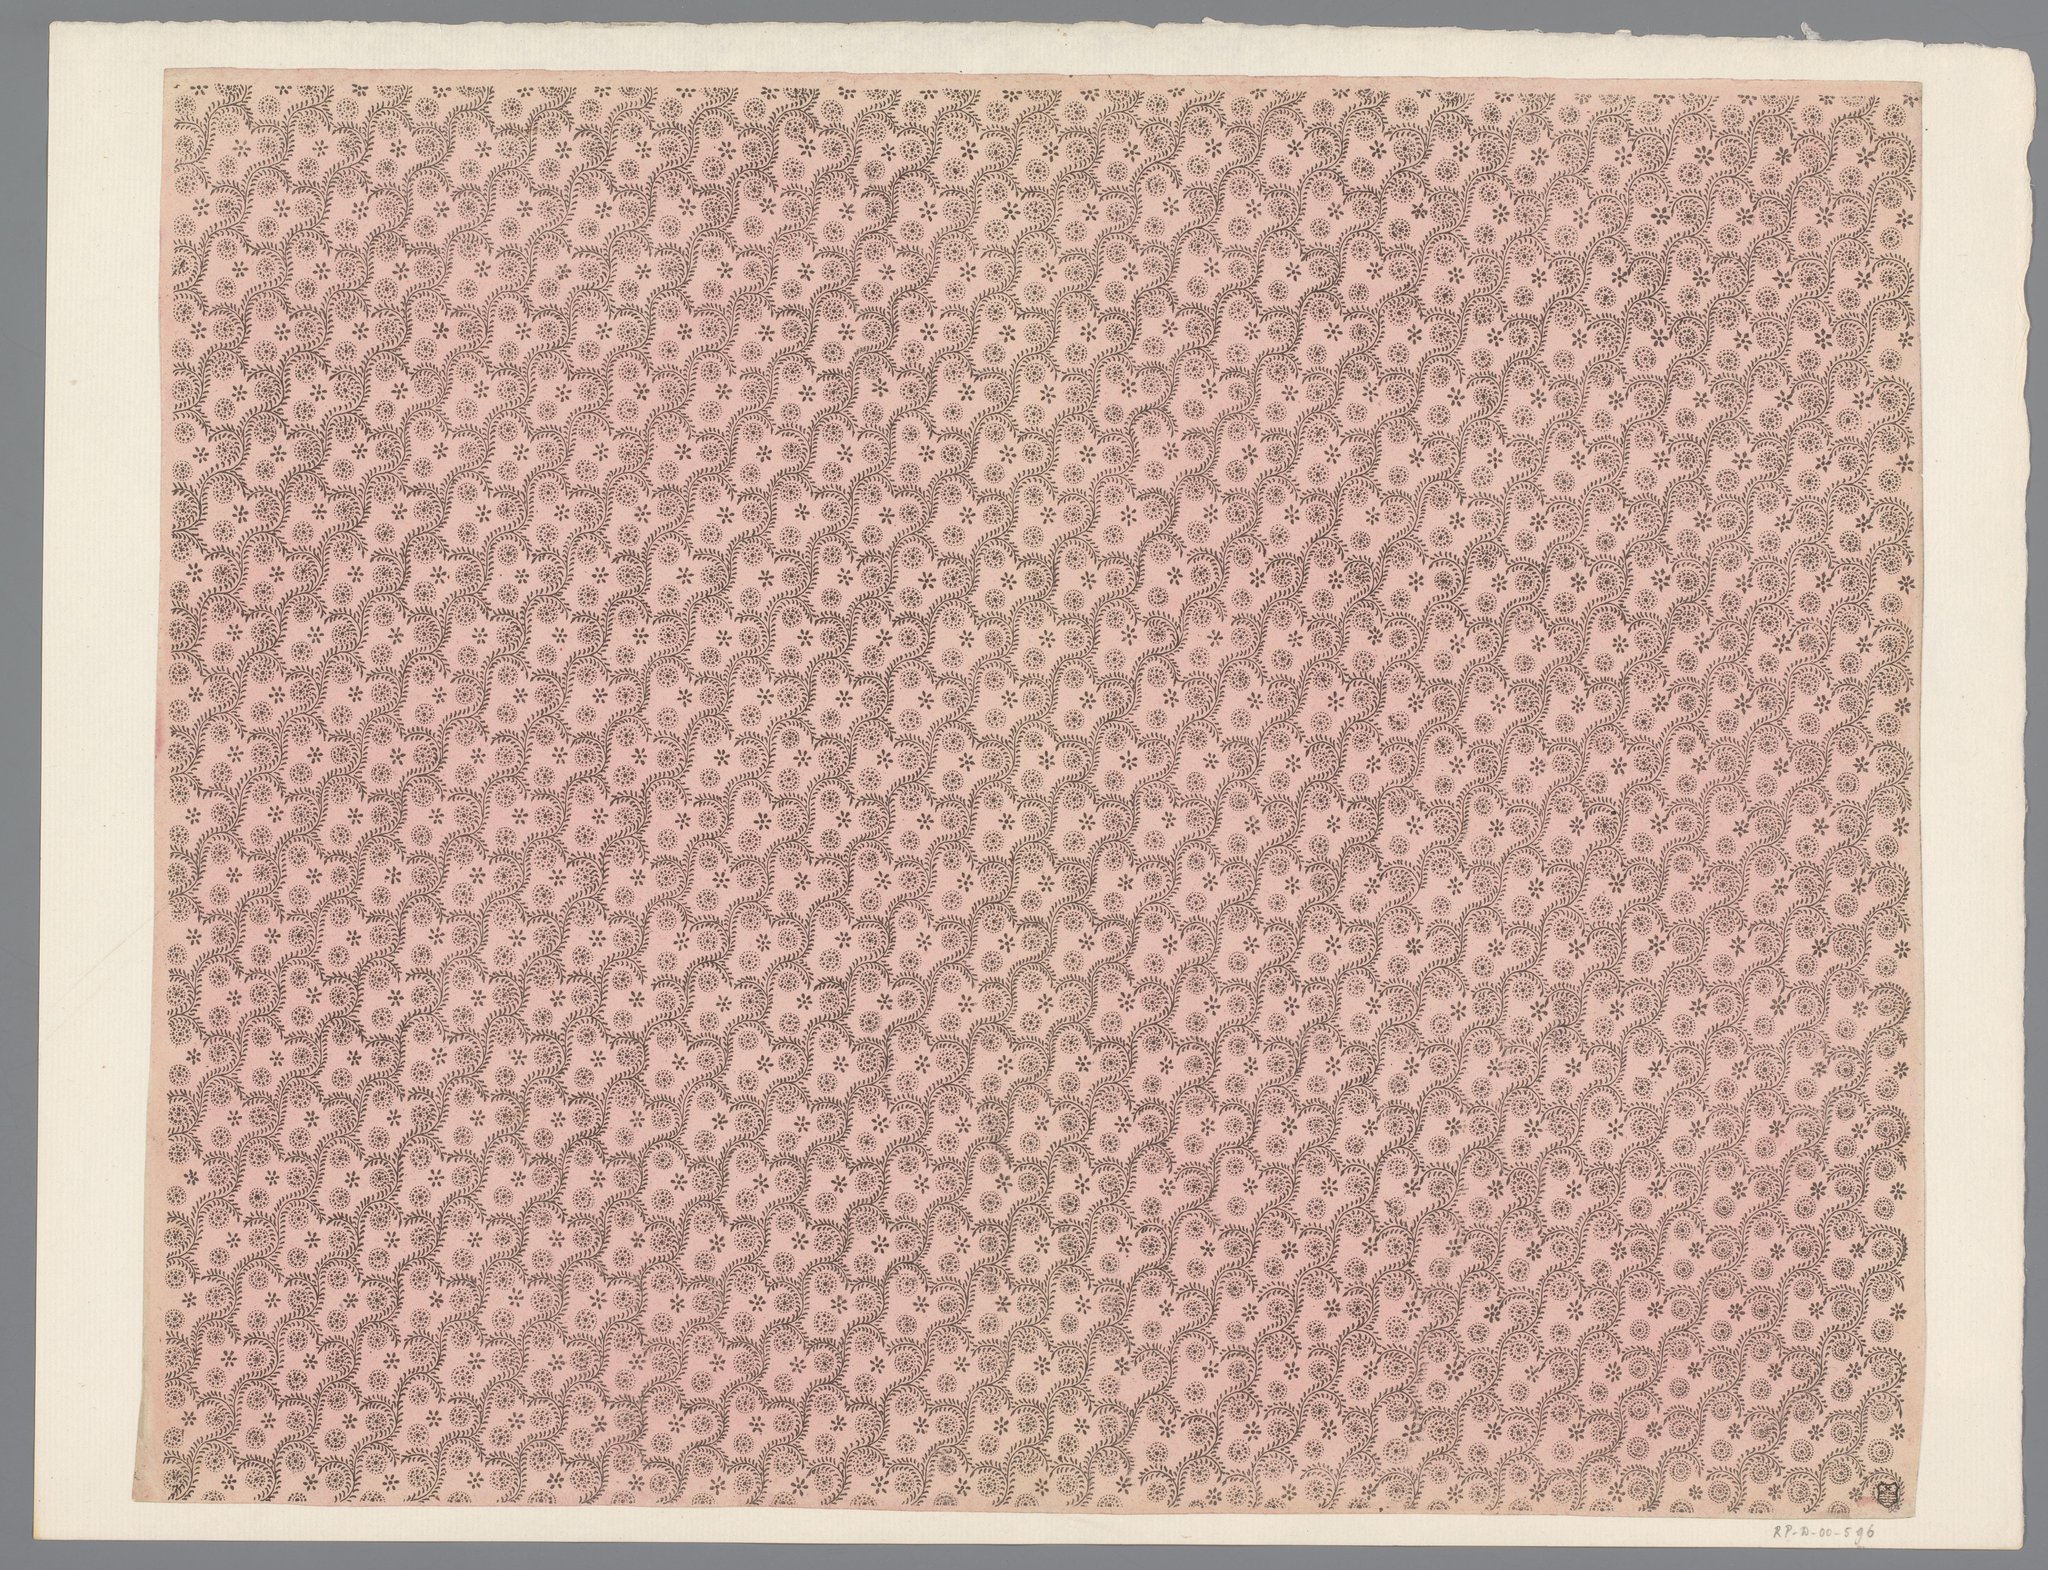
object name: printed paper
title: Blad met patroon van diagonale banen van aan elkaar verbonden ranken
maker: Anonymous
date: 1800-1900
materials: paper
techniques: printing block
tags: ornament derived from plant forms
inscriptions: collector's mark: Lugt 2760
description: Blad met patroon van diagonale banen van aan elkaar verbonden ranken met bladeren.